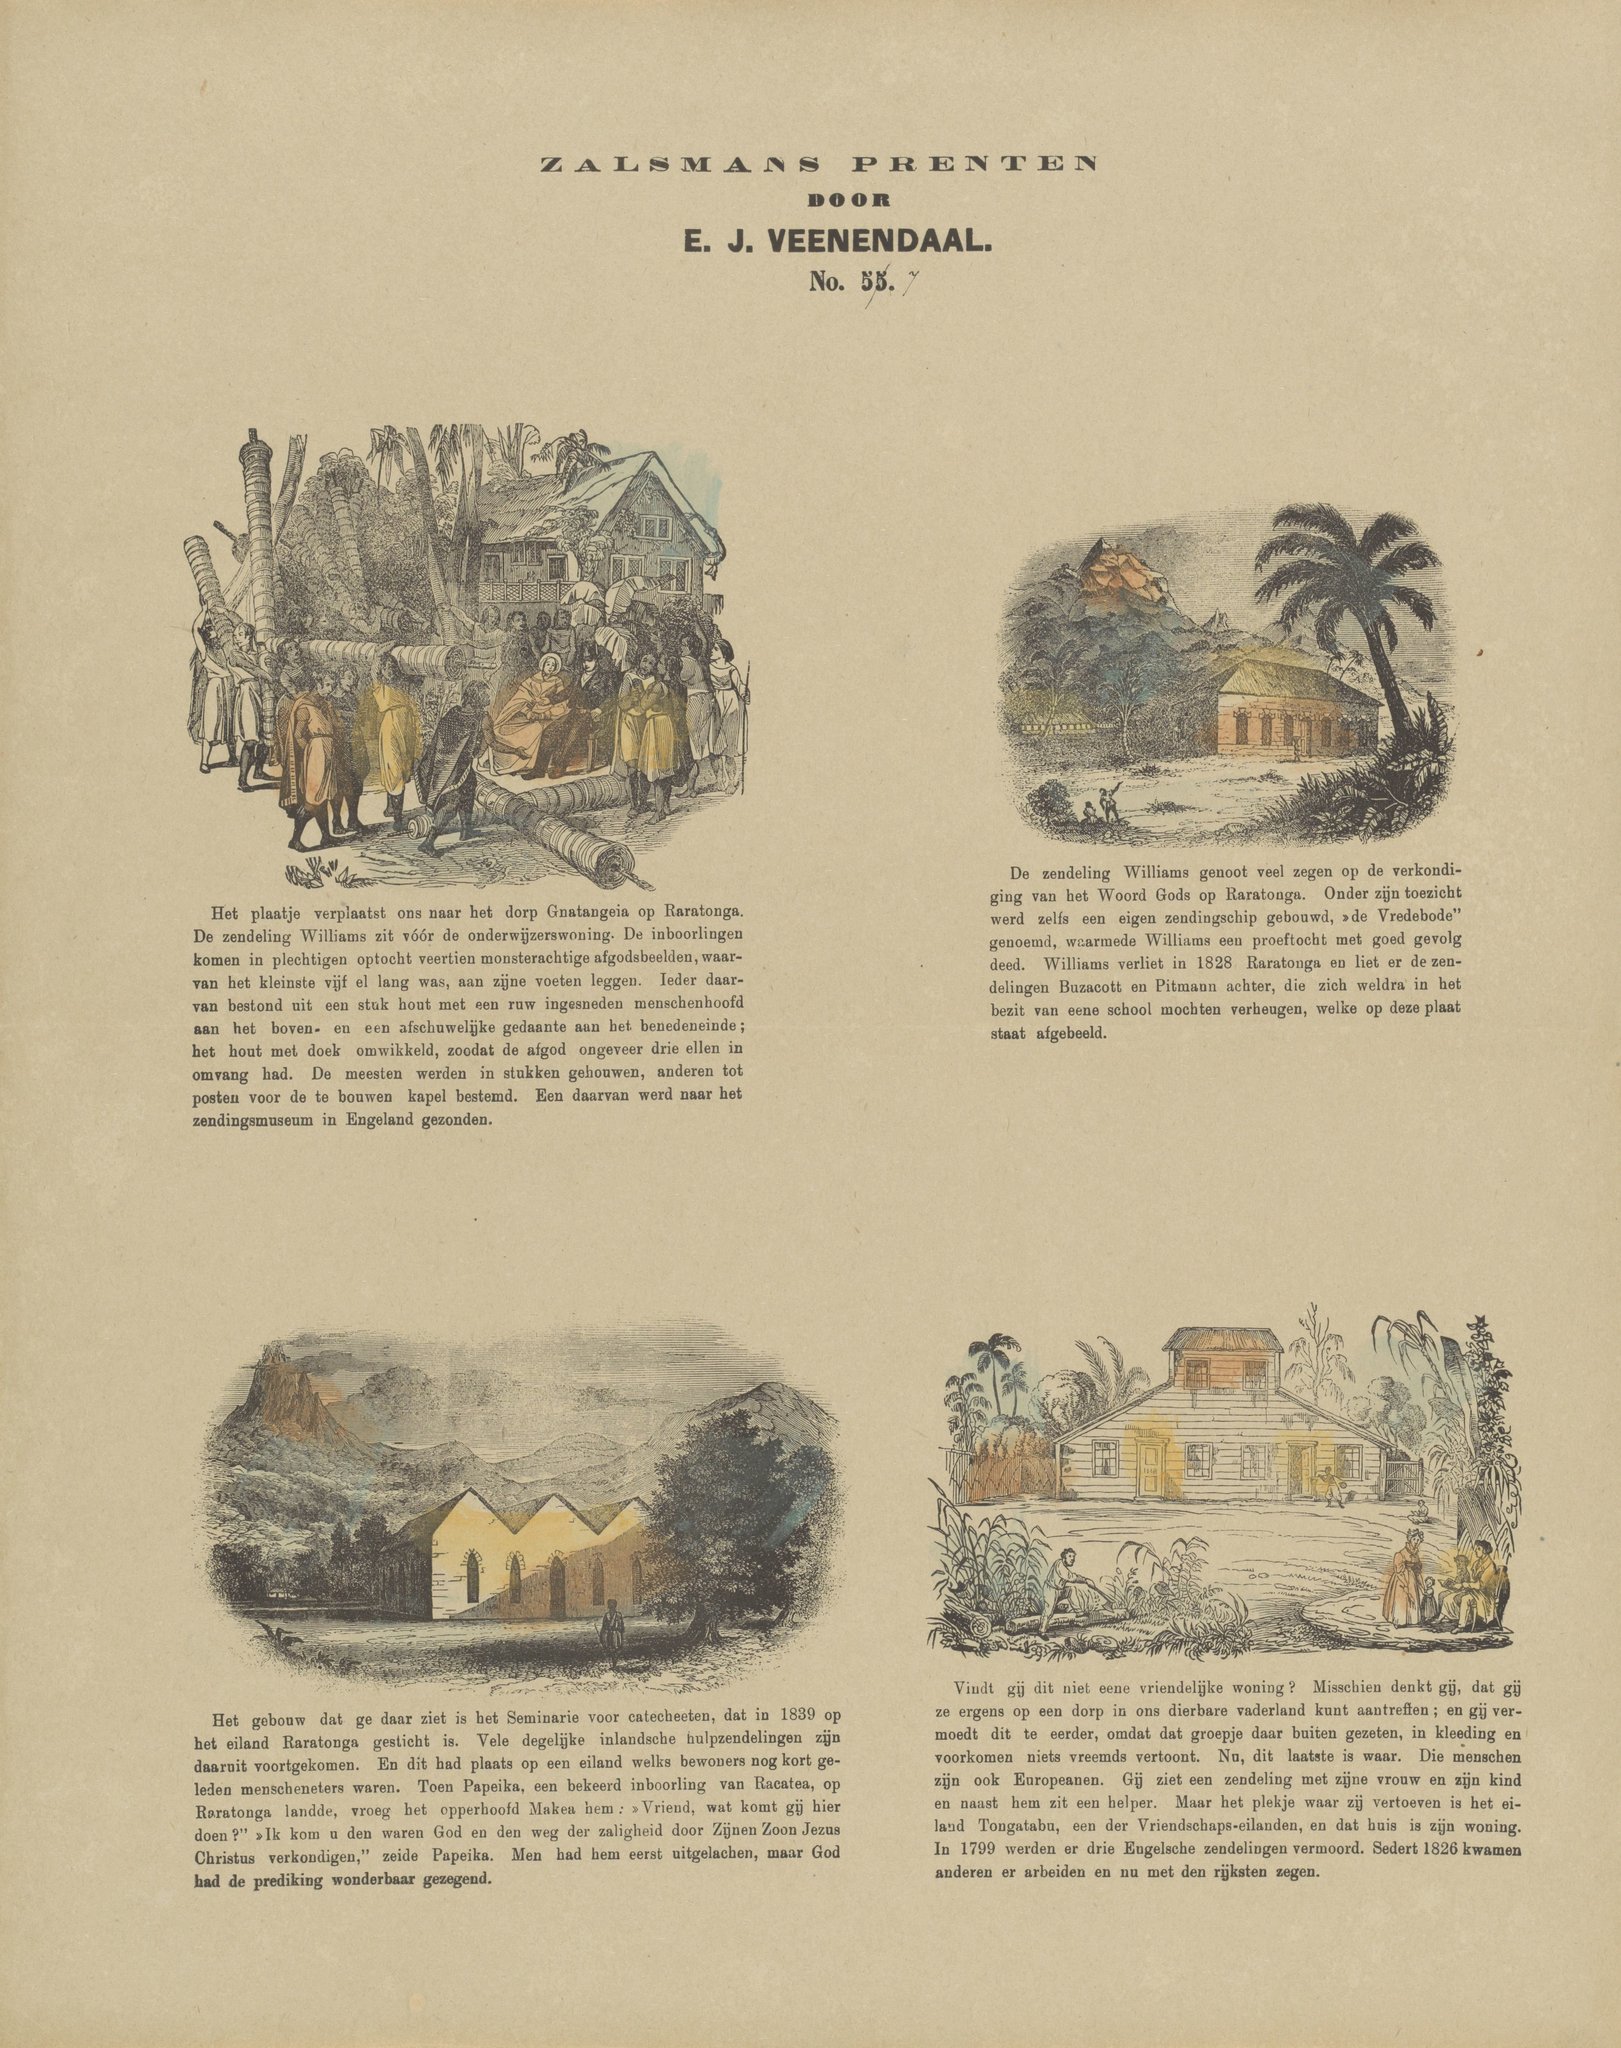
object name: popular print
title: John Williams op Samoa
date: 1869-1882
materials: paper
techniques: colour, letterpress printing, engraving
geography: europe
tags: missionary, ships (in general), spreading the gospel; missionary work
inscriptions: collector's mark: Lugt 2760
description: Blad met 4 voorstellingen van de missionaris John Williams op Rarotonga. Onder elke afbeelding een onderschrift. Genummerd midden boven: No. 55.